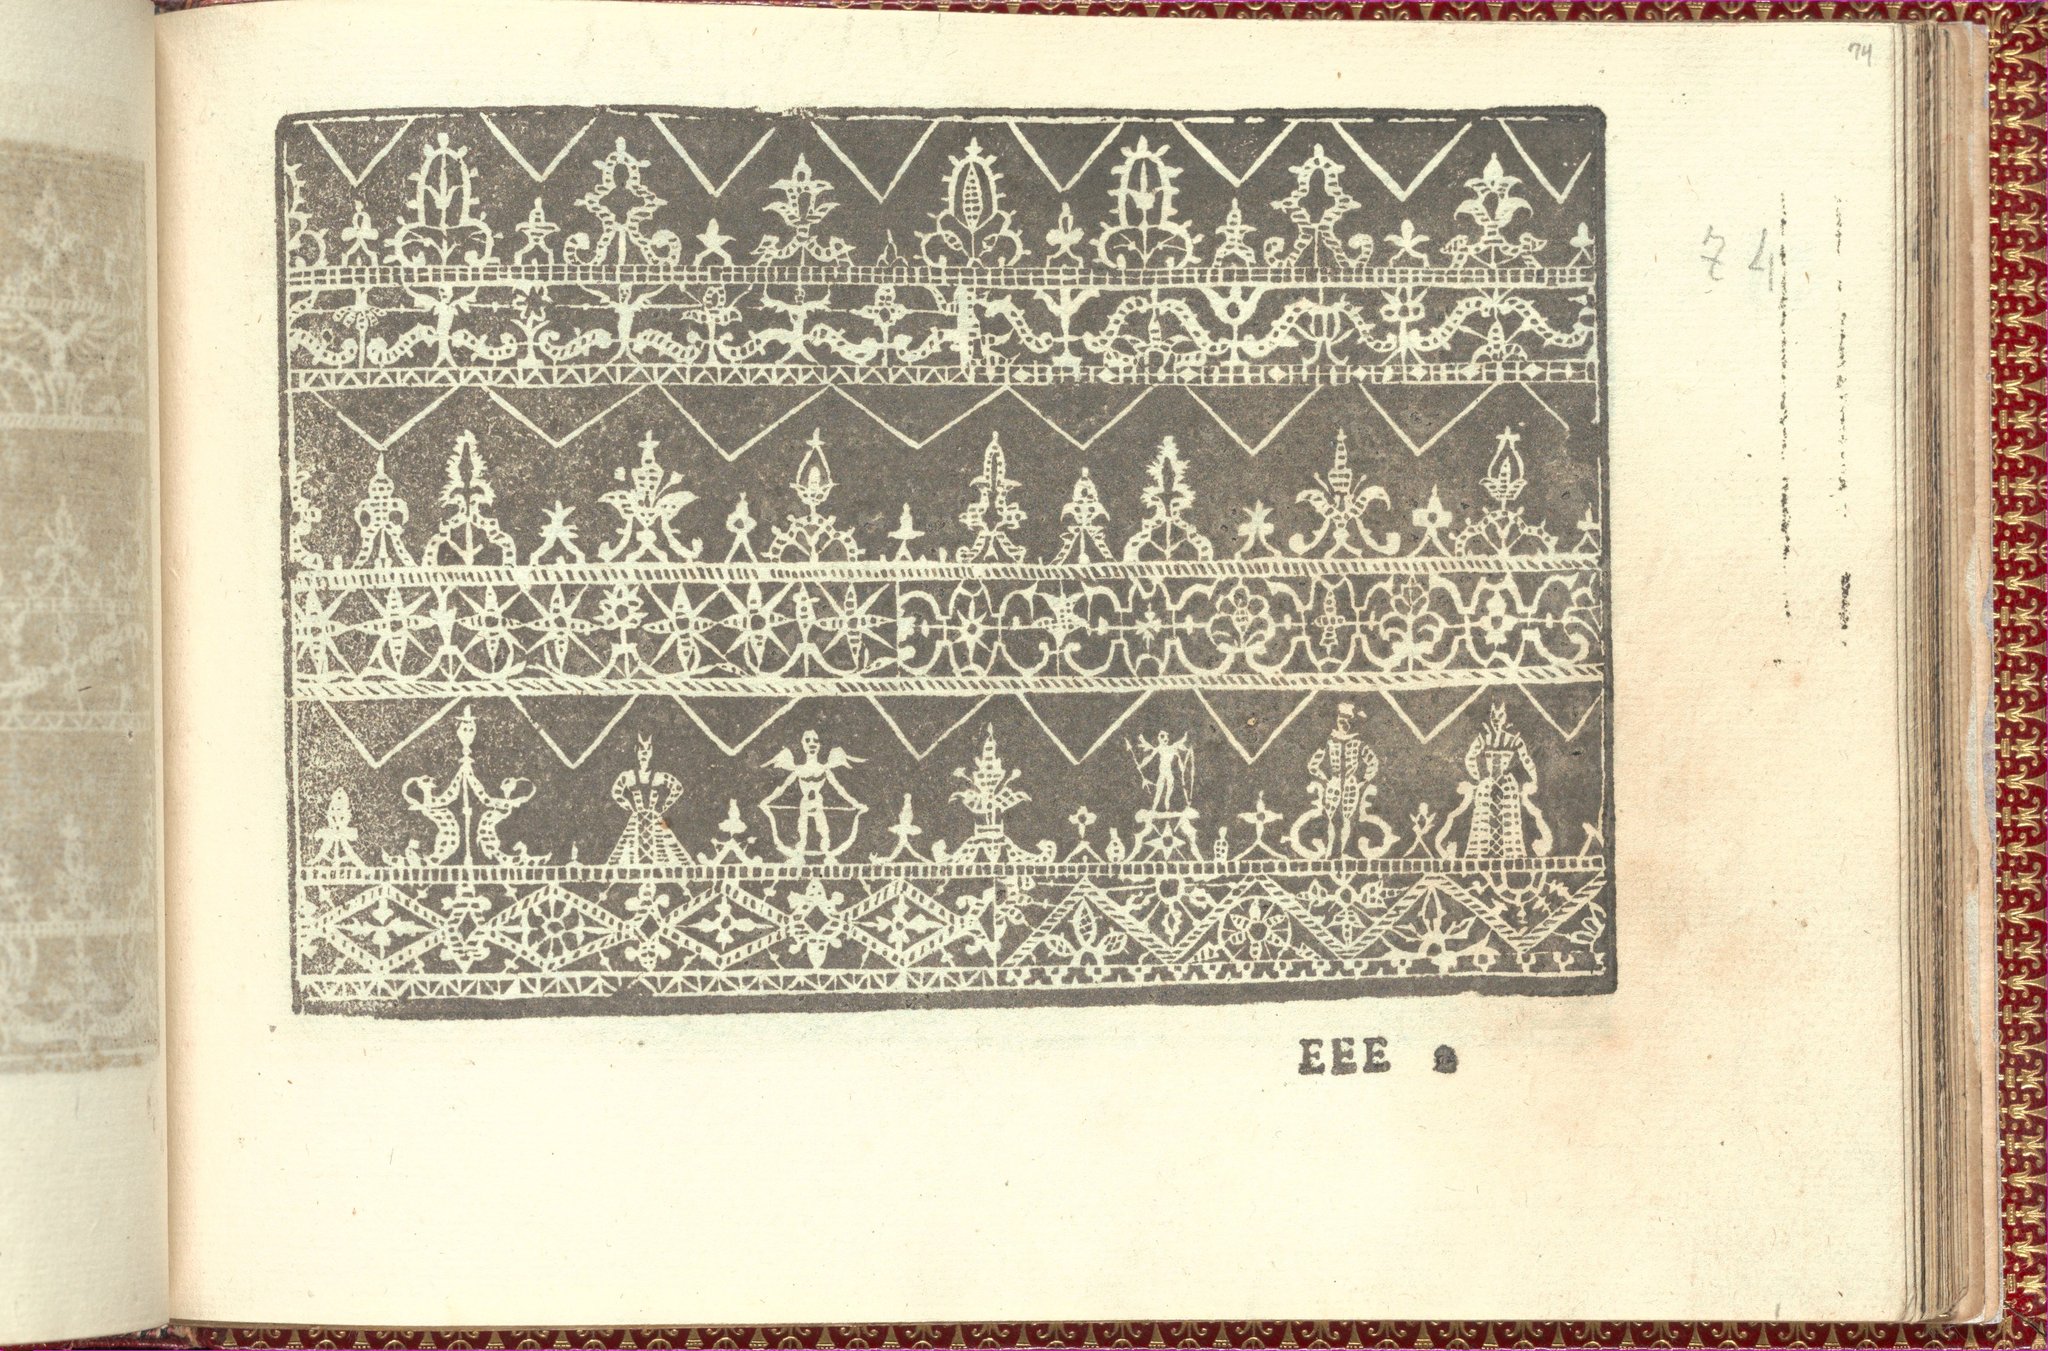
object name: book print ornament architecture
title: Corona delle Nobili et Virtuose Donne: Libro I-IV, page 74 (recto)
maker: cesare vecellio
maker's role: publisher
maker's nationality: italian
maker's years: 1521-1601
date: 1601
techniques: woodcut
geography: italy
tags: ornament